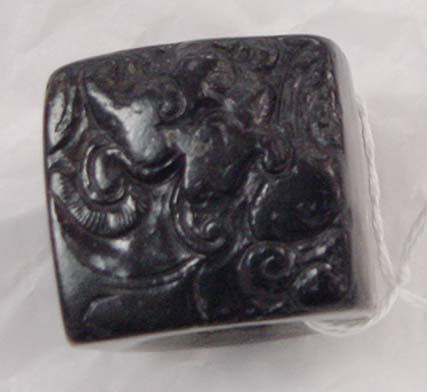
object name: ring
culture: chinese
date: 1801-1900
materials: jade